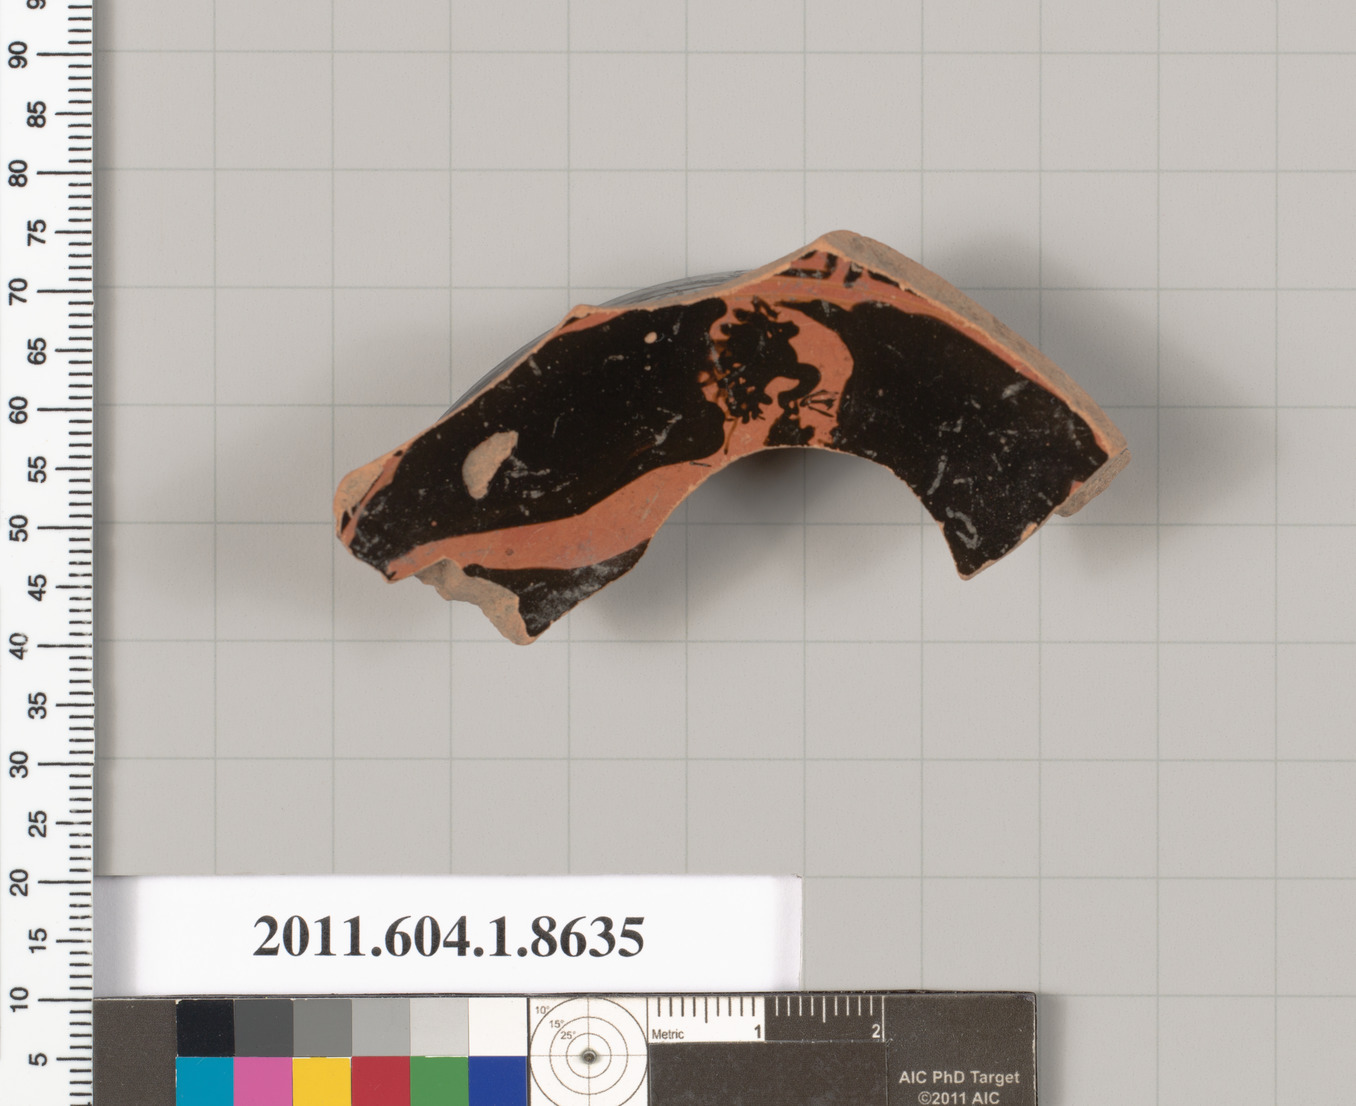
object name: kylix fragment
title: Terracotta fragment of a stemless kylix (drinking cup)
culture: greek, attic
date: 467-435 BCE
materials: terracotta